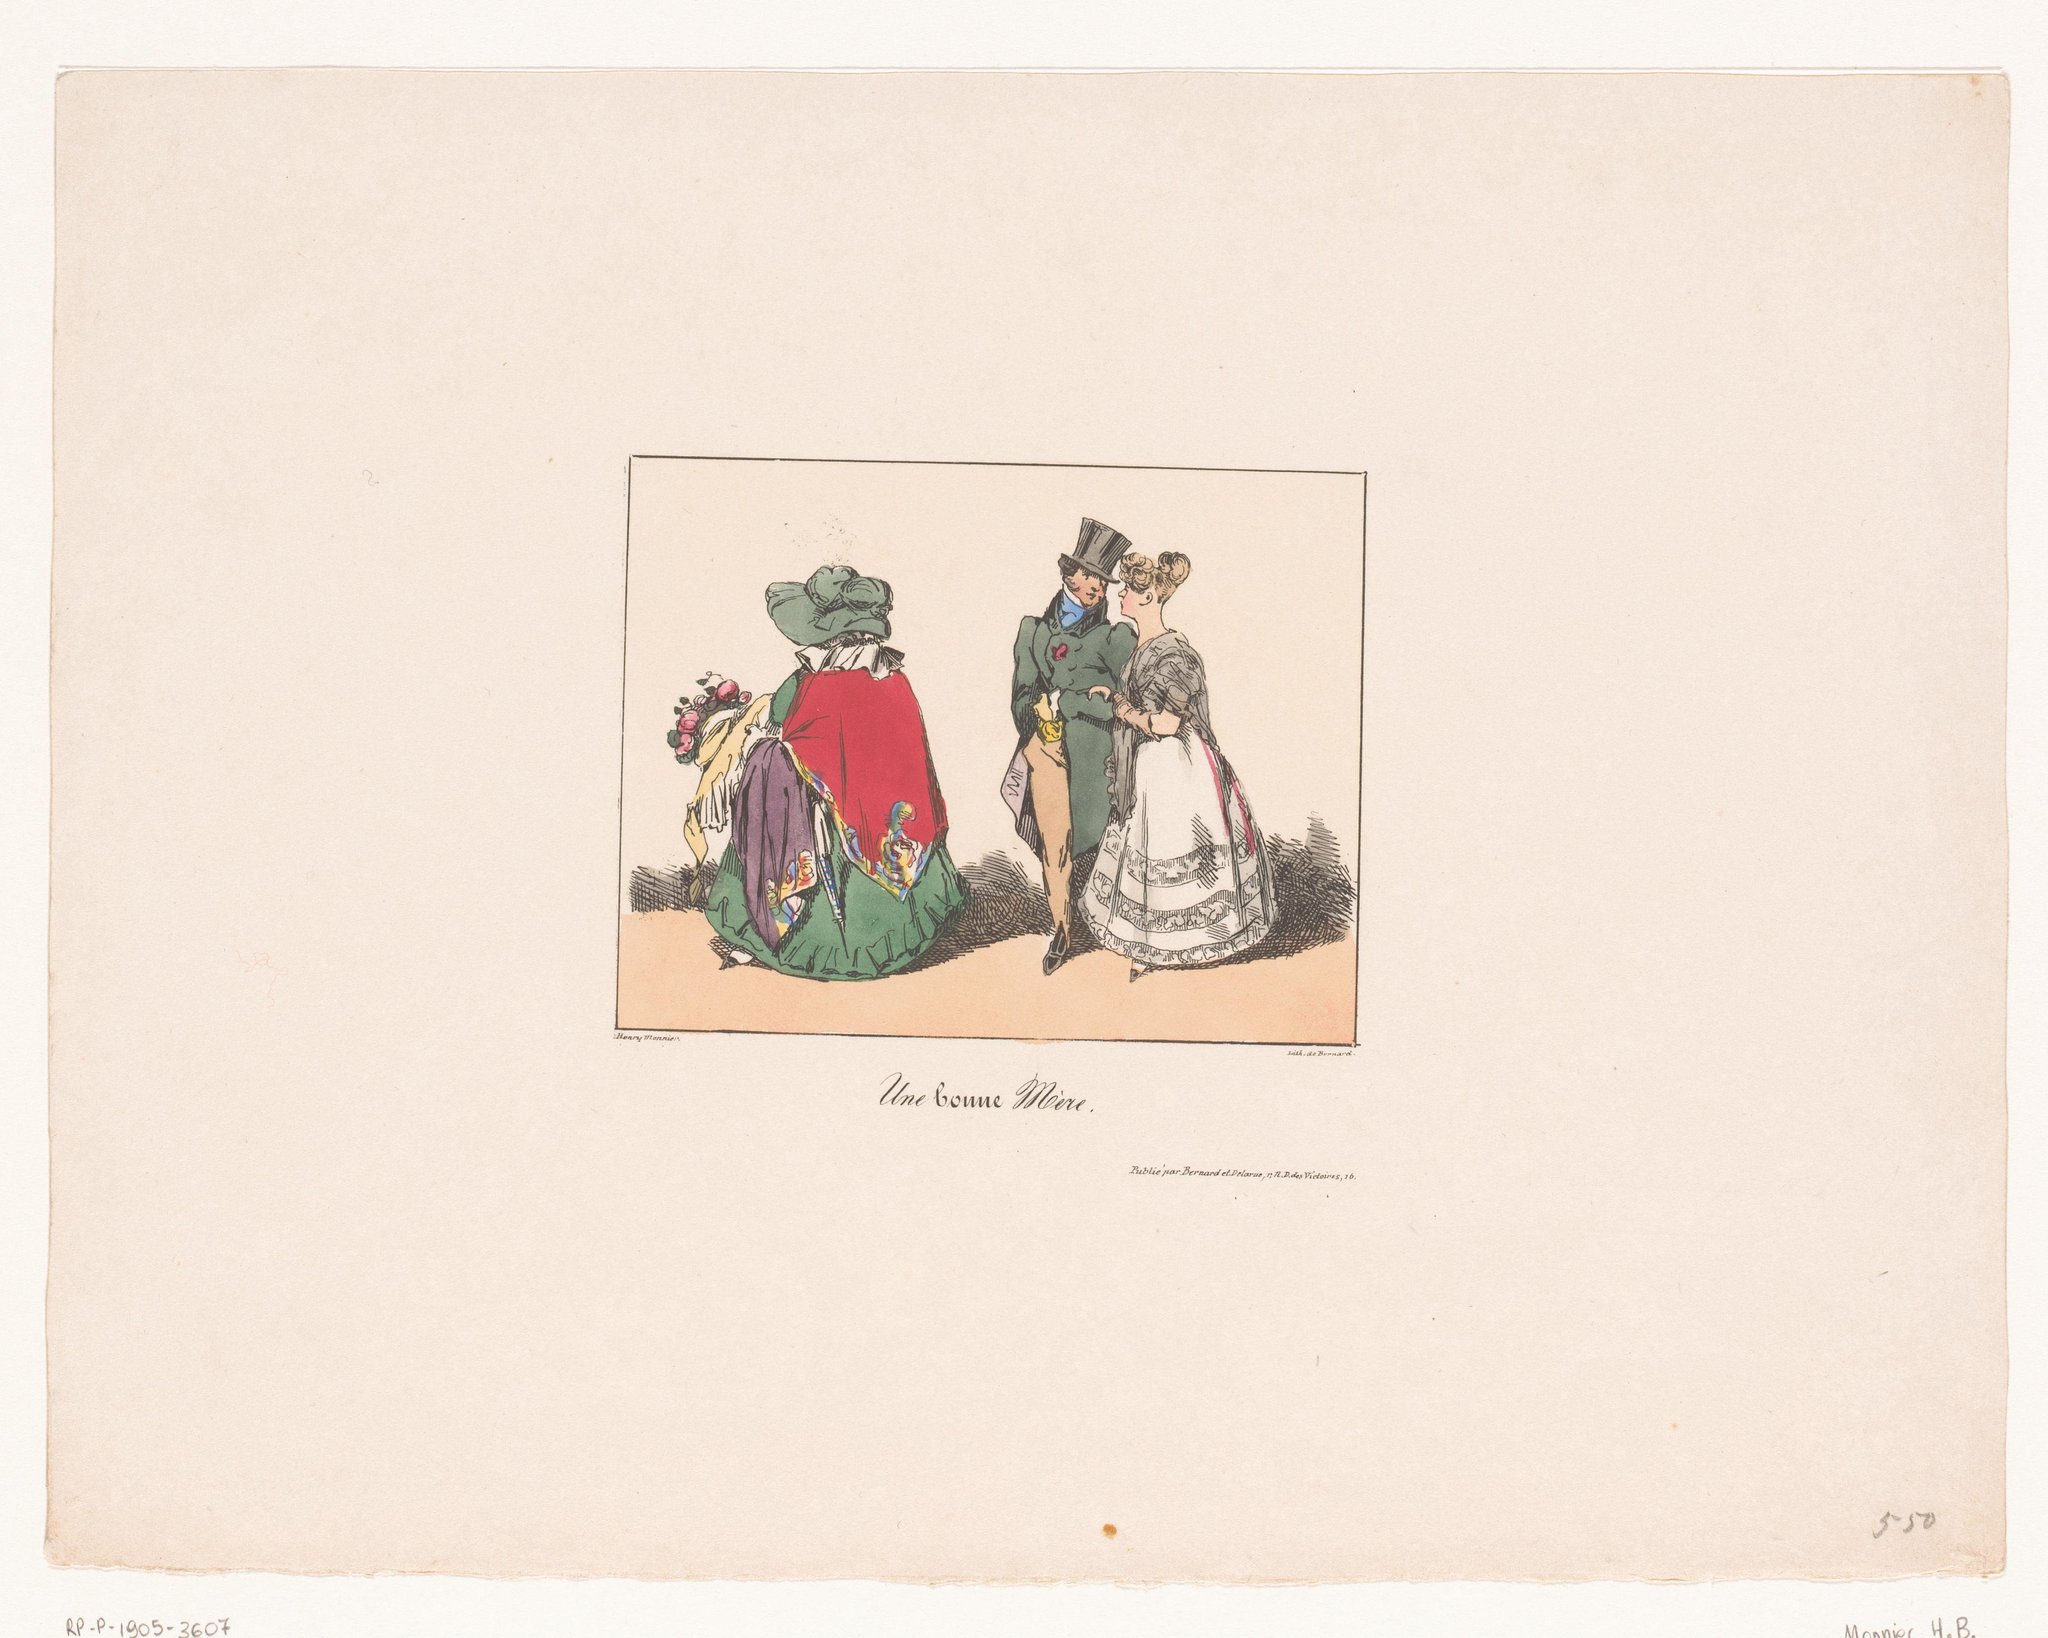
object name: print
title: Levendig Parijs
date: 1826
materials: paper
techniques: hand coloring, lithograph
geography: paris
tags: mother-love, couple of lovers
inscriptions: collector's mark: Lugt 2228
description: De prentserie werd in 1826 in twee afleveringen van tien prenten uitgebracht. Zie voor de eerste aflevering: Bibliographie de la France (1826), nr. 51, 28 juni 1826, p. 568. Voor de tweede aflevering: Bibliographie de la France (1826), nr. 67, 23 augustus 1826 p. 728.